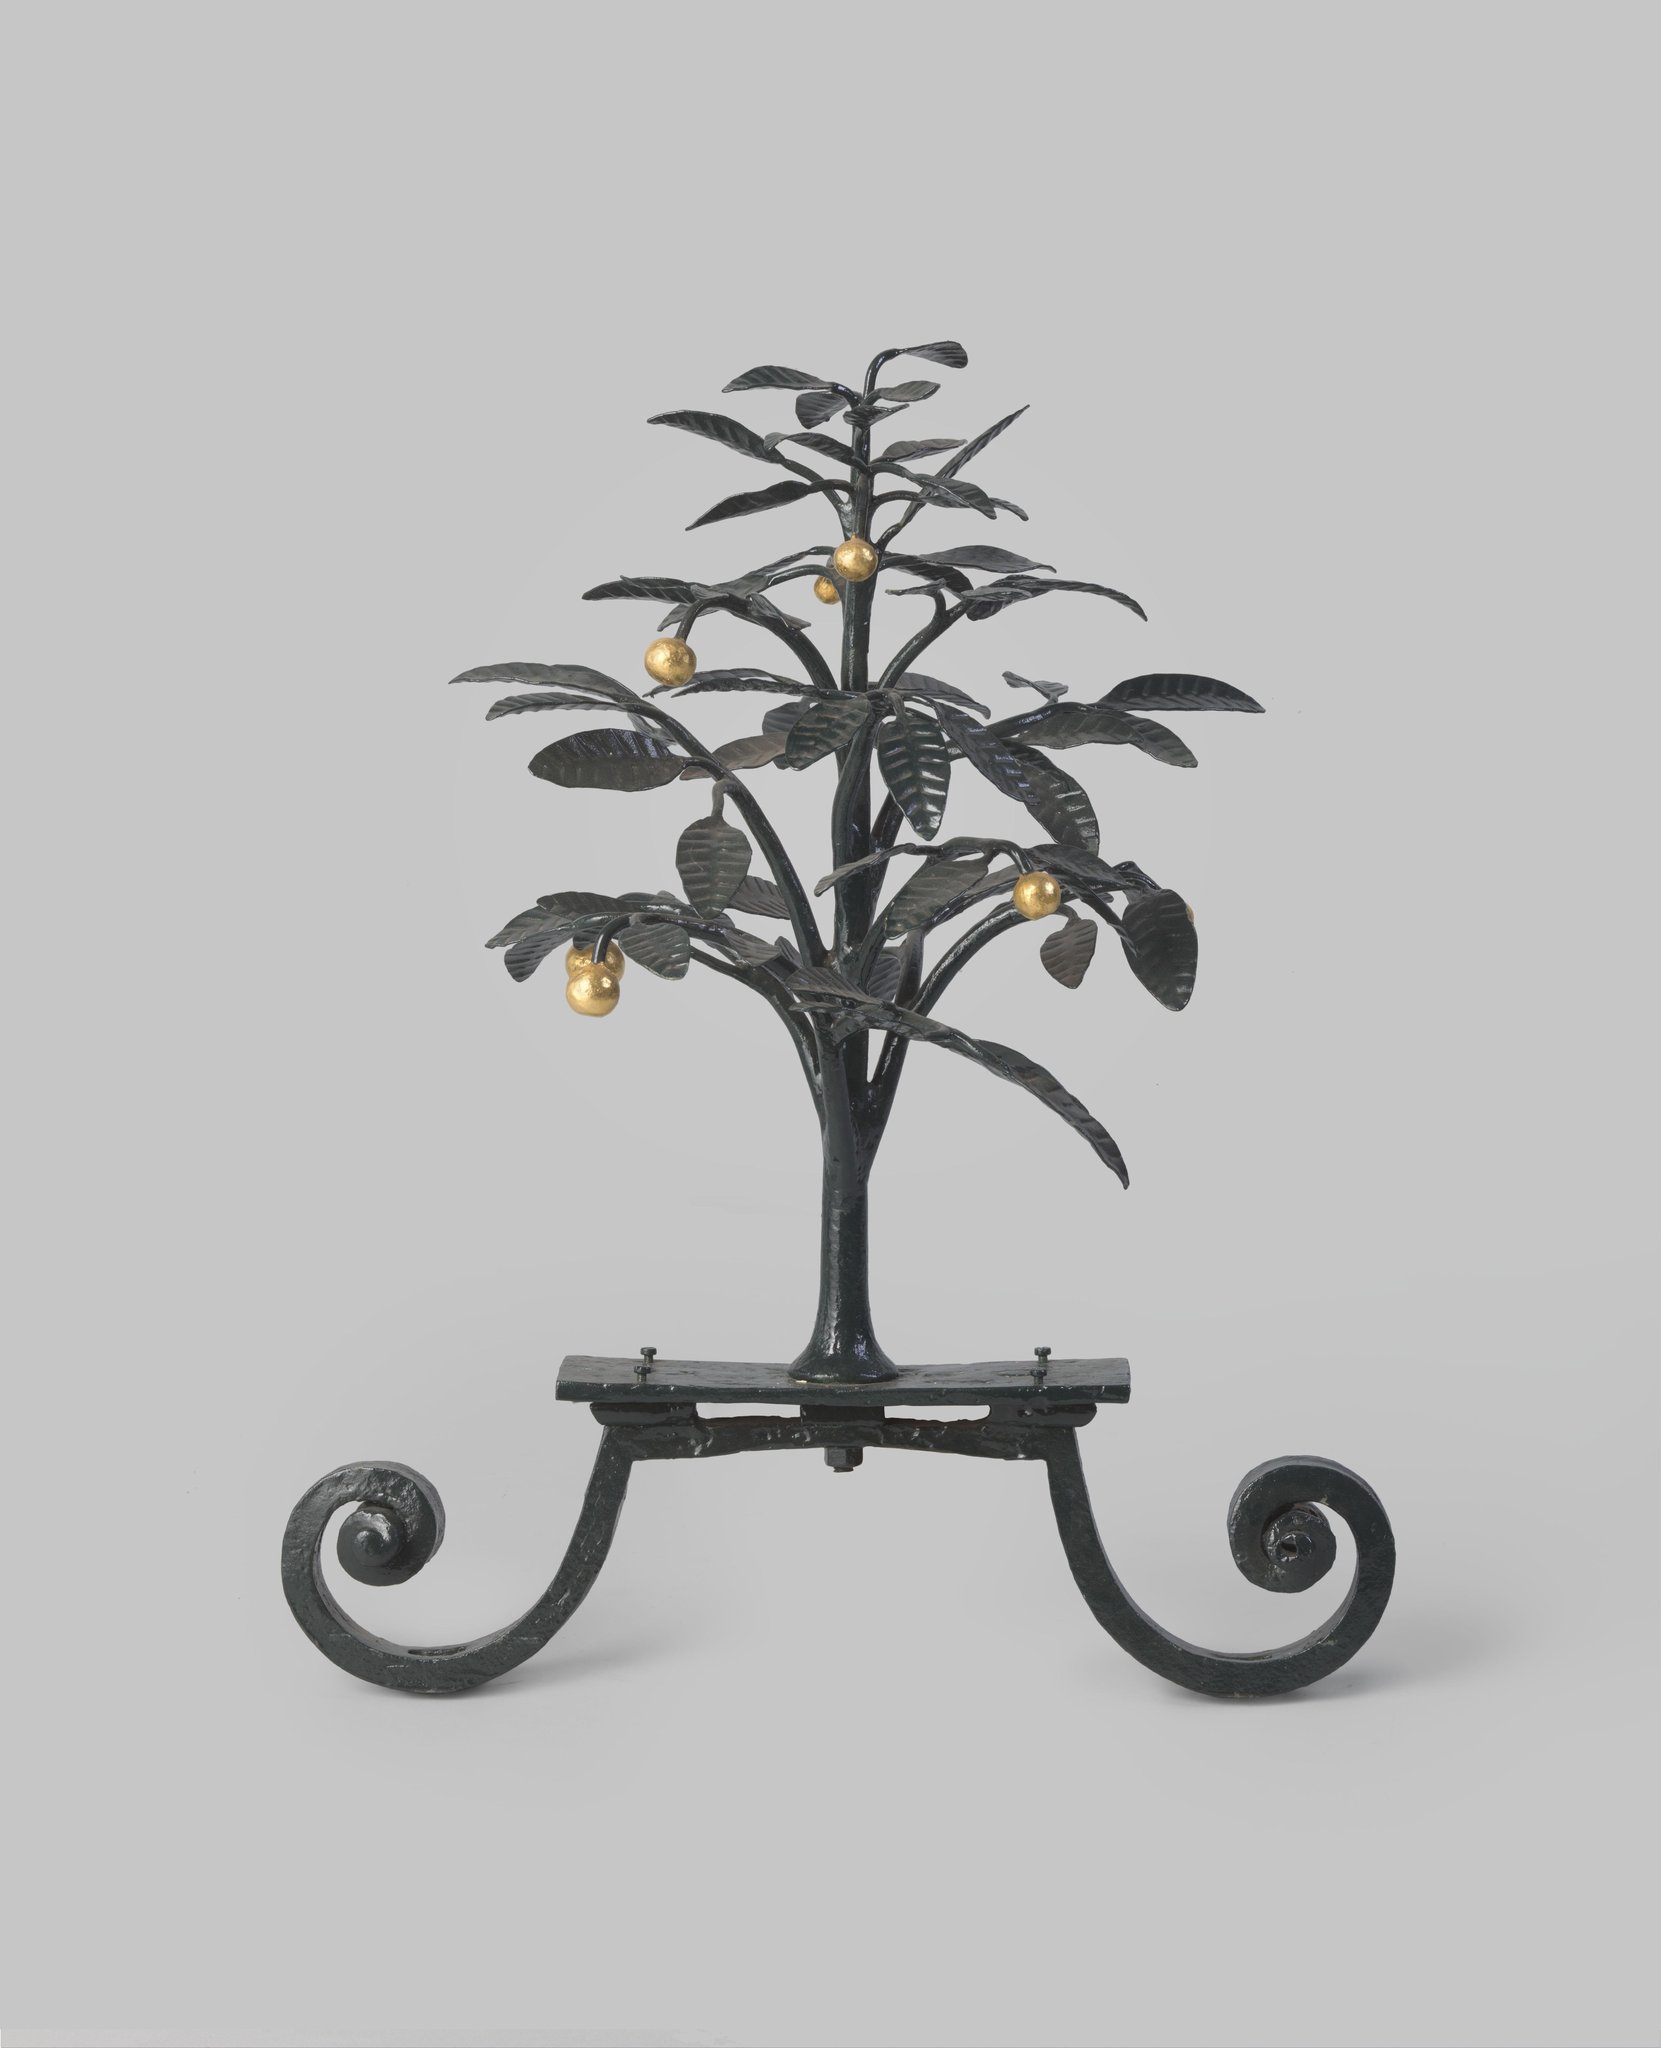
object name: hek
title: Inrijhek Huize de Voorst bij Warnsveld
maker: daniël marot (i)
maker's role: draughtsman, print maker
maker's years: 1661-1752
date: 1675-1700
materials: iron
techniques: forging, gilding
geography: warnsveld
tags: huis de voorst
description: De hekvleugels zijn aangebracht tussen open hekstijlen, bestaande uit twee op enige afstand van elkaar geplaatst stijlen waarbij de tussenruimte is gevuld met symmetrisch ornament in Lodewijk XIV-vormen. Aan weerszijden zijn gesloten spijlenvakken geplaatst, op dezelfde wijze uitgevoerd als de hekvleugels en aan de buitenzijden afgesloten door open hekstijlen van dezelfde vorm. De buitenste stijlen zijn geplaatst tegen de natuurstenen balustrade van de brug. Aan weerszijden van de stijlen zijn rijk uitgevoerde zijstukken met voluutvormen aangebracht, deels op de balustrade rustend en aan de buitenzijde daarvan vastgezet. Deze zijstukken bezitten een overdaad aan florale motieven en grillig gevormde punten langs de buitenranden. De bovenzijde van het hekwerk is uitgevoerd in een rechte lijn. Het geheel wordt zo omgeven door een rechthoekige omraming waartegen de grillige lijnen van de zijstukken zich scherp aftekenen. De afsluitende lijn aan de bovenzijde bestaat uit een doorlopende geprofileerde ligger. Op deze ligger zijn lanspunten geplaatst in de lijn van de vierkante hekspijlen. Op de ligger zijn boven de vier open hekstijlen gesmede ijzeren boompjes met oranjeappeltjes geplaatst. Het hek wordt gesteund door in totaal acht lage en smalle schoren die tegen de hekstijlen zijn aangebracht. Niet bekend is in welk jaar het oorspronkelijke hek werd vervaardigd, dat thans in de tuin van het Rijksmuseum staat. Op een gravure van P. Schenk van omstreeks 1700 staat een hek dat in grote lijn overeenkomt met het huidige hek, maar de detaillering is anders. Op een vogelvlucht door Daniël Marot staat echter een hek afgebeeld dat meer overeenkomt met het huidige hek. Op deze gravure zijn boven de hekstijlen bekroningen aangegeven die lijken op de smeedijzeren boompjes op het huidige hek. Boven de doorgang is echter een bekroning getekend die aan het oorspronkelijke hek bij het Rijksmuseum ontbreekt. Ondanks de verschillen in de weergave op oude gravures en het bestaande hek, lijkt dit, gelet op zowel de algehele uitvoering als de detaillering, te dateren uit de bouwtijd van het huis of van kort daarna. Rechterdeel van het nieuwe brughek.